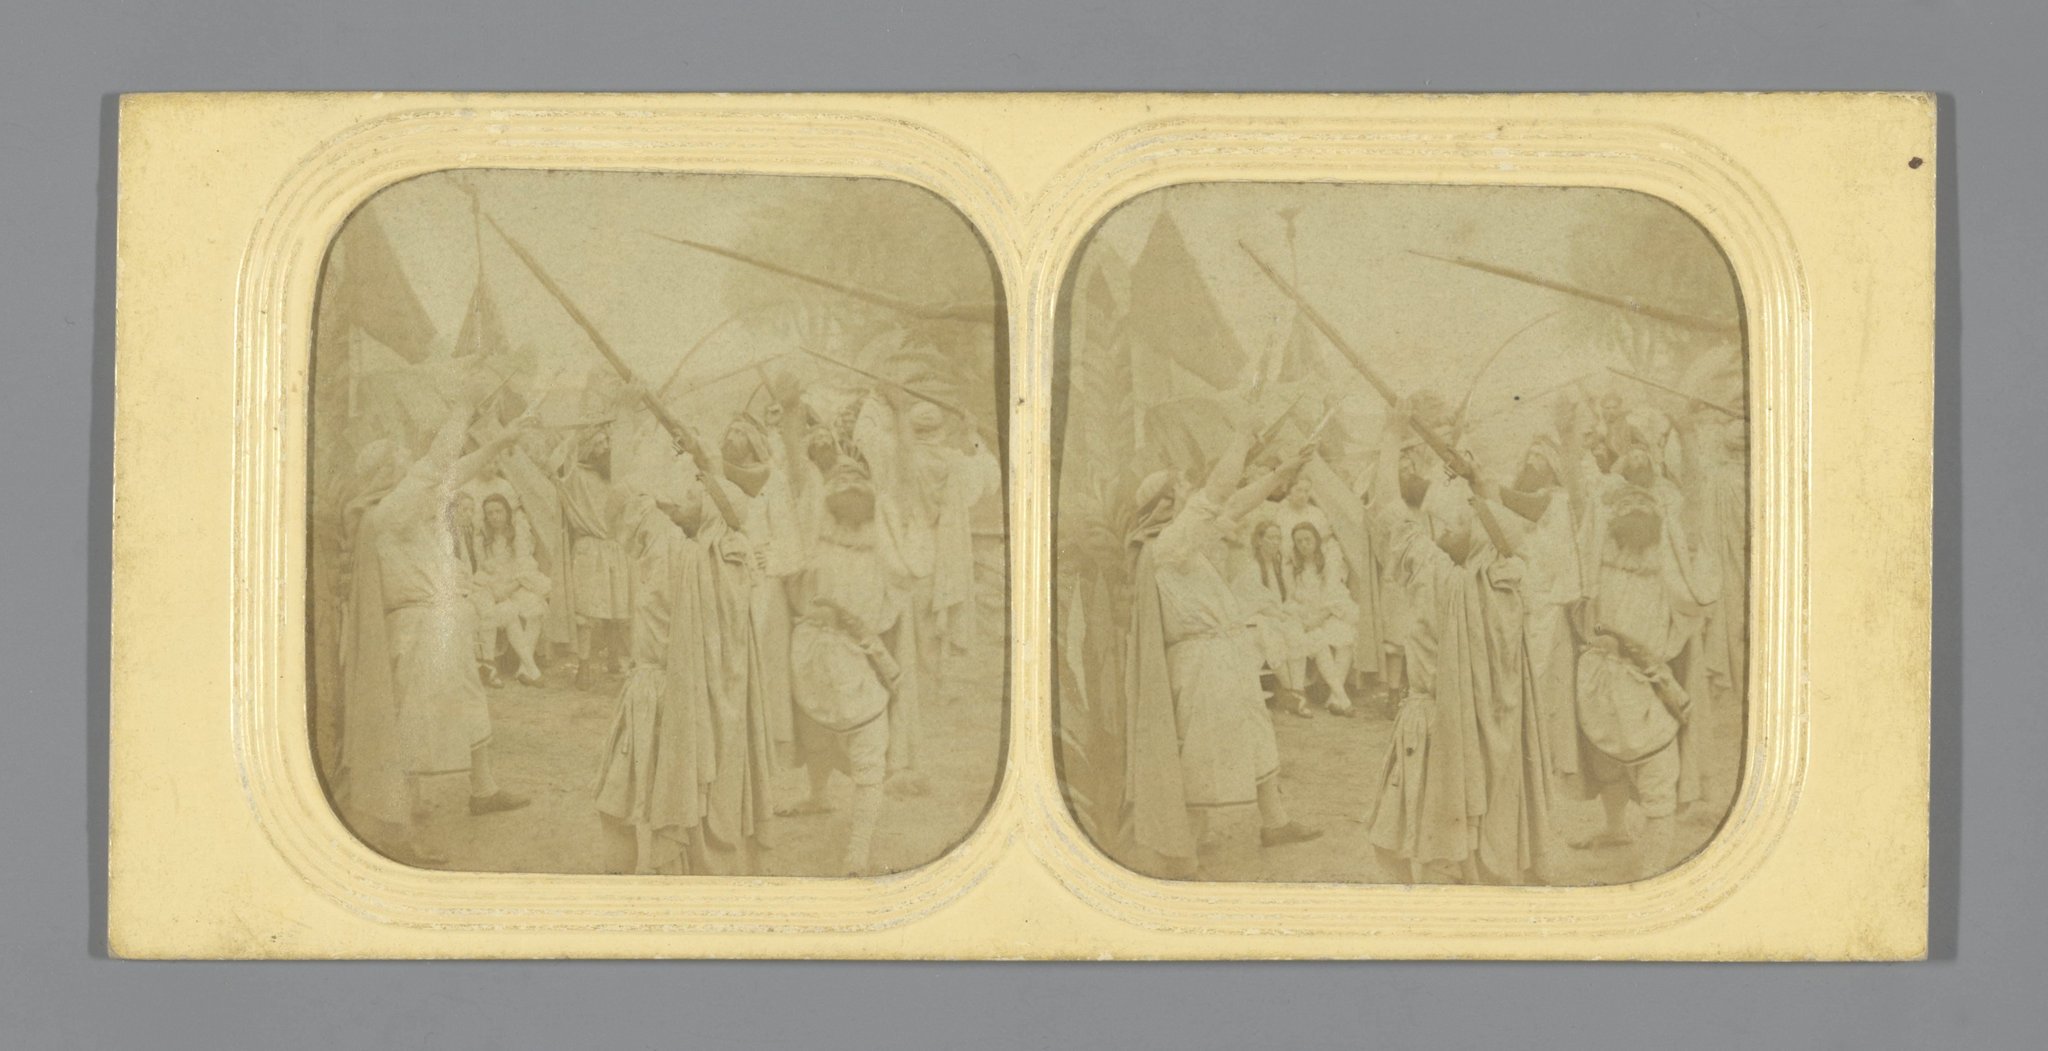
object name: tissue stereograph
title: Mannen wijzen met geweren naar de lucht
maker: Anonymous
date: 1855-1875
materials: cardboard, paper, photographic support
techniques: albumen print, cutting, hand coloring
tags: firearms